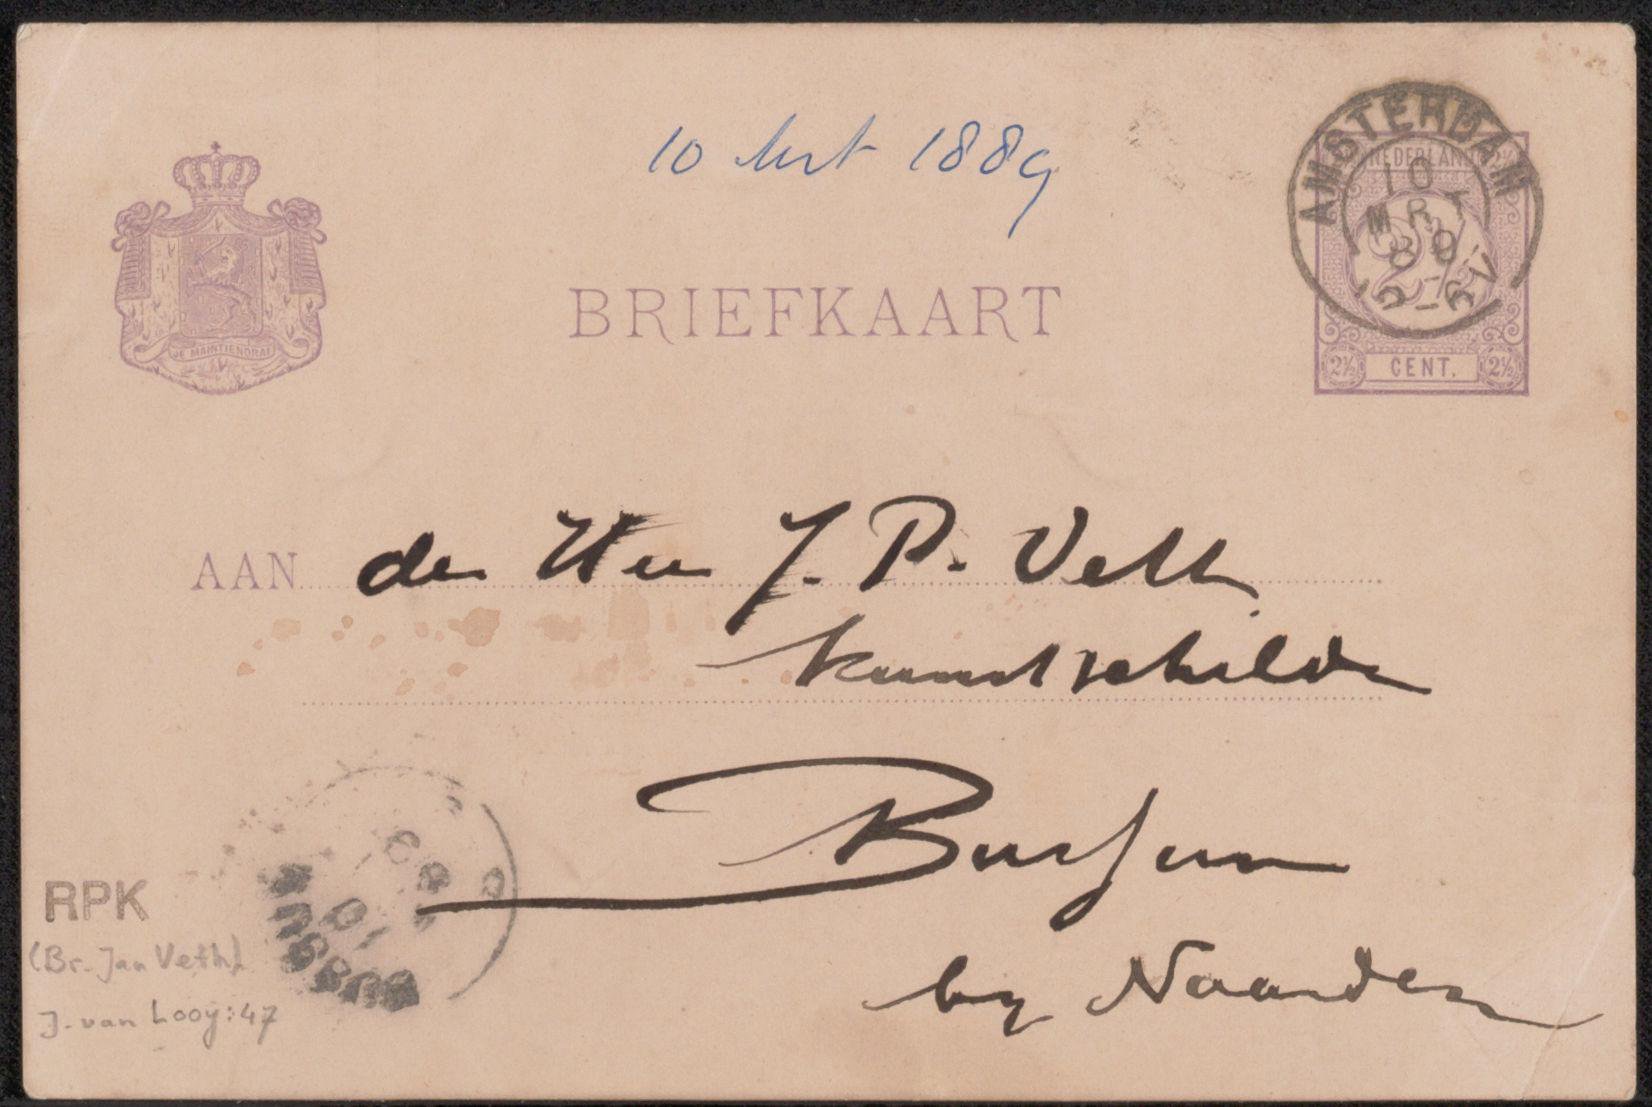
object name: postcard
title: Briefkaart aan Jan Veth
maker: jac van looij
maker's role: draughtsman, painter, print maker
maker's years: 1855-1930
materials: cardboard, ink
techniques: pen, writing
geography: amsterdam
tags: august allebé, dordrecht, designer, jan veth, willem witsen, the graphic arts, paris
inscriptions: collector's mark: ‘RPK’